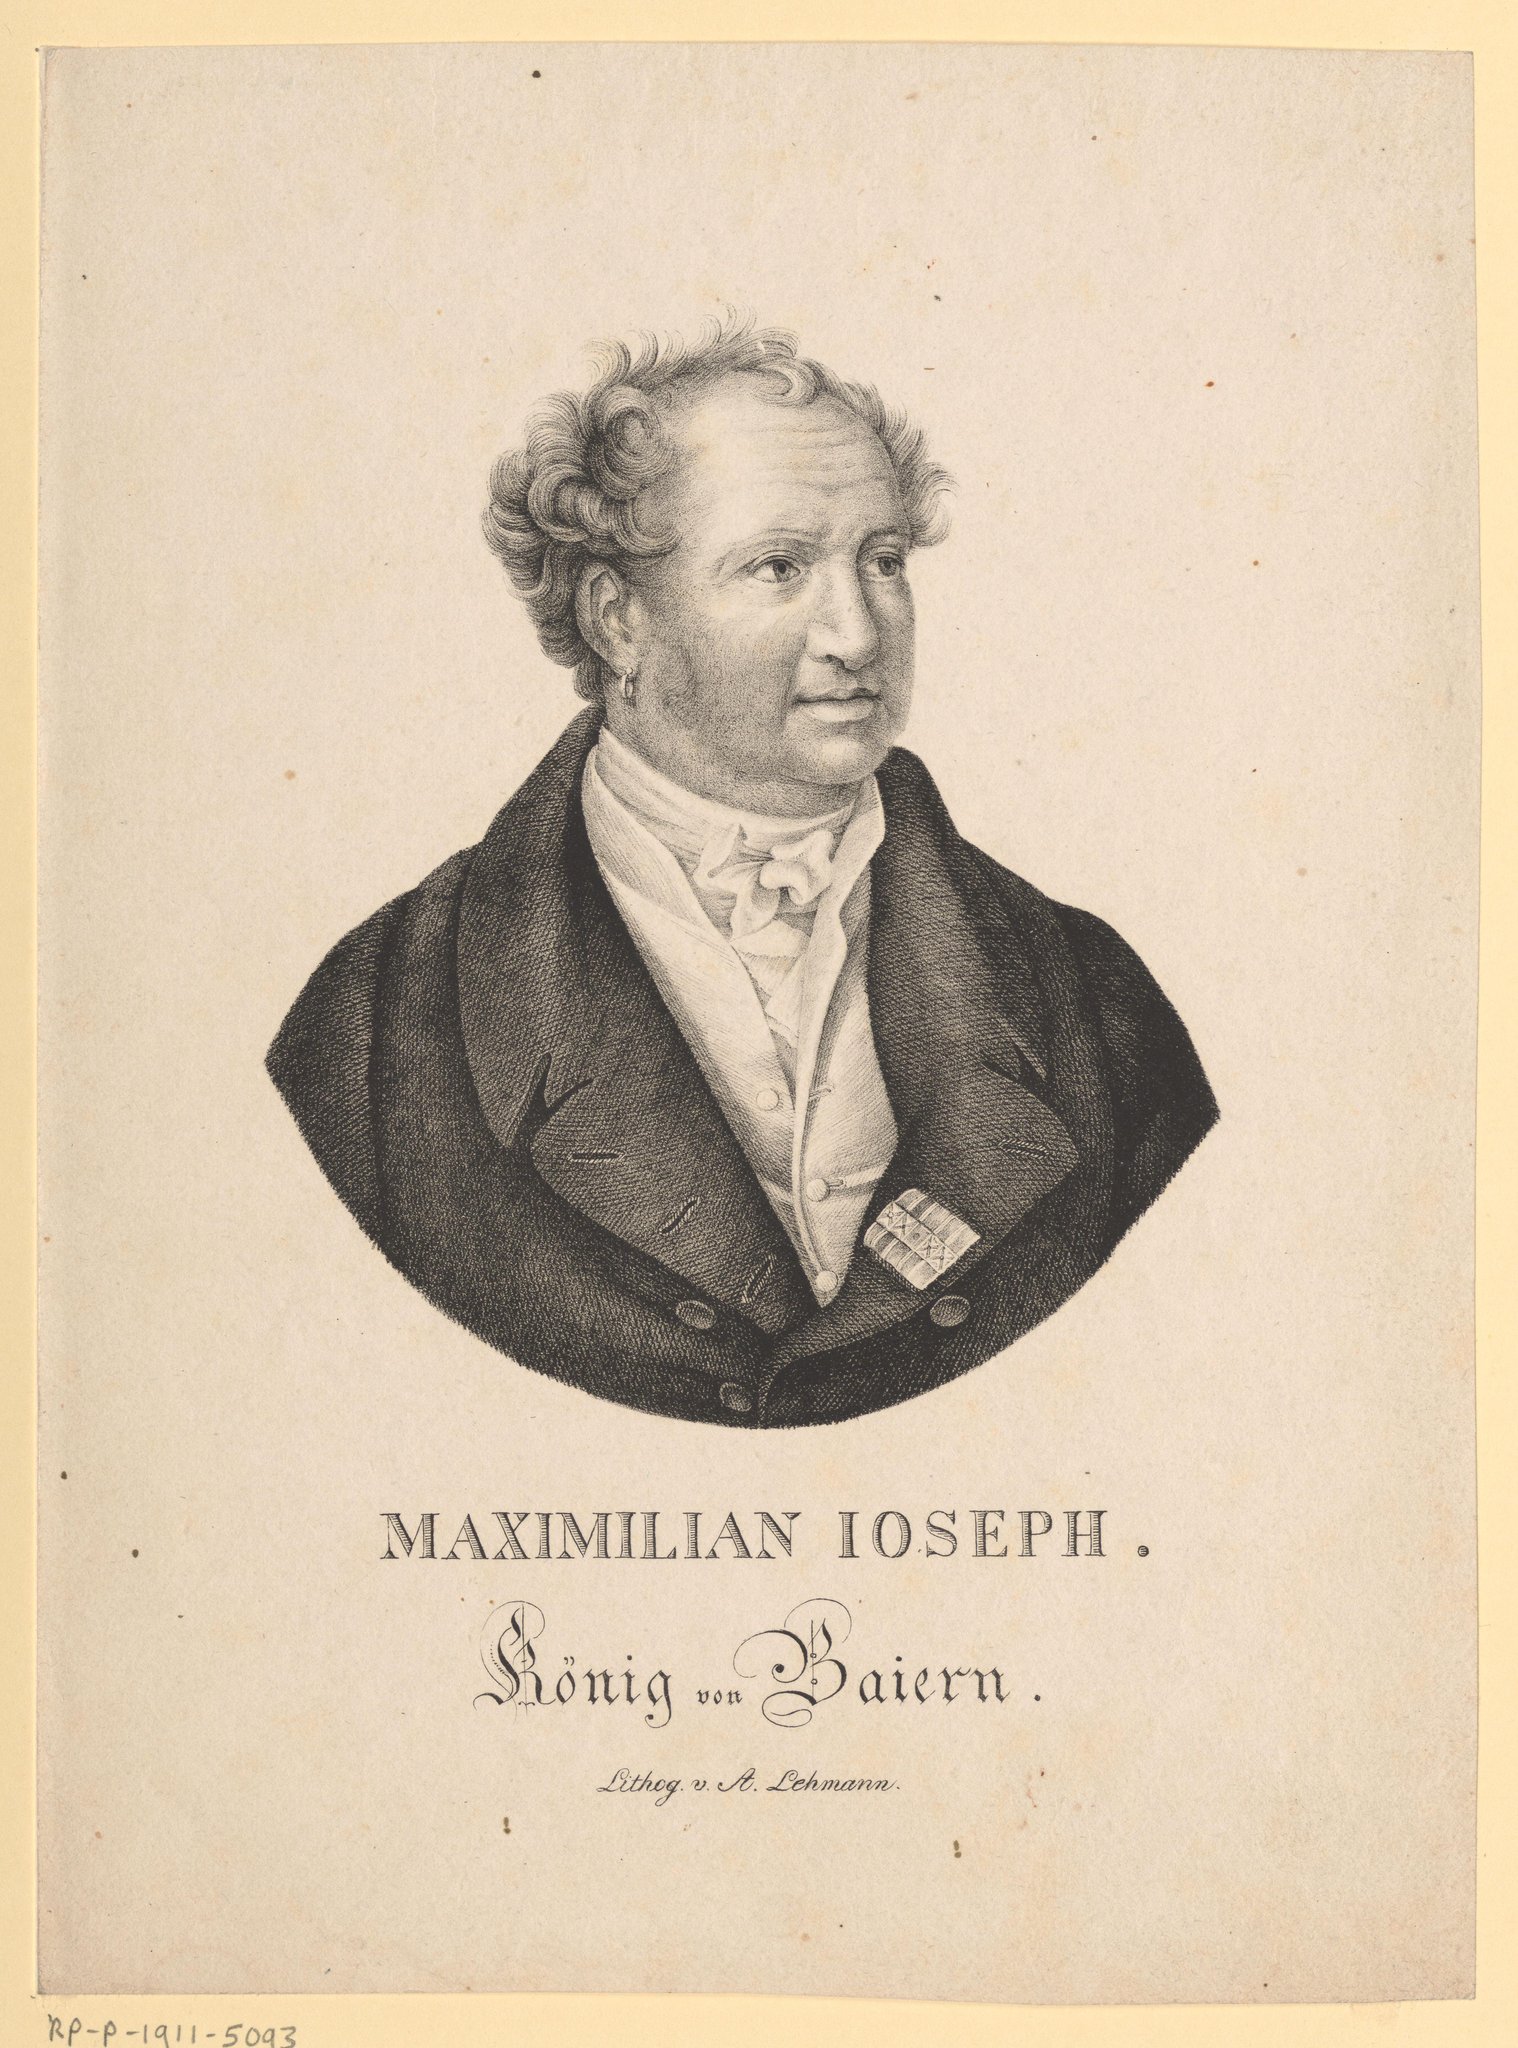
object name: print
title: Portret van Maximiliaan I Jozef van Beieren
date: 1806-1821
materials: paper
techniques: lithograph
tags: maximiliaan i jozef (koning van beieren), historical persons, king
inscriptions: collector's mark: Lugt 2228